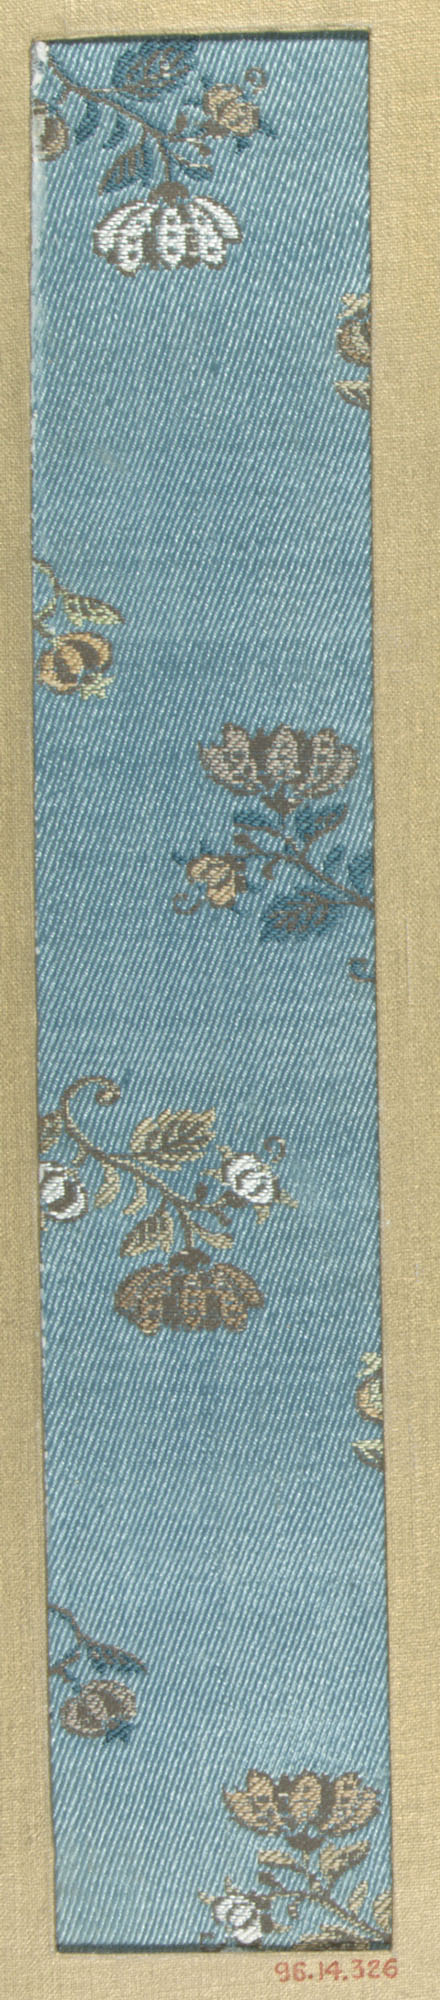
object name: piece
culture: japanese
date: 1701-1900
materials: silk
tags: leaves